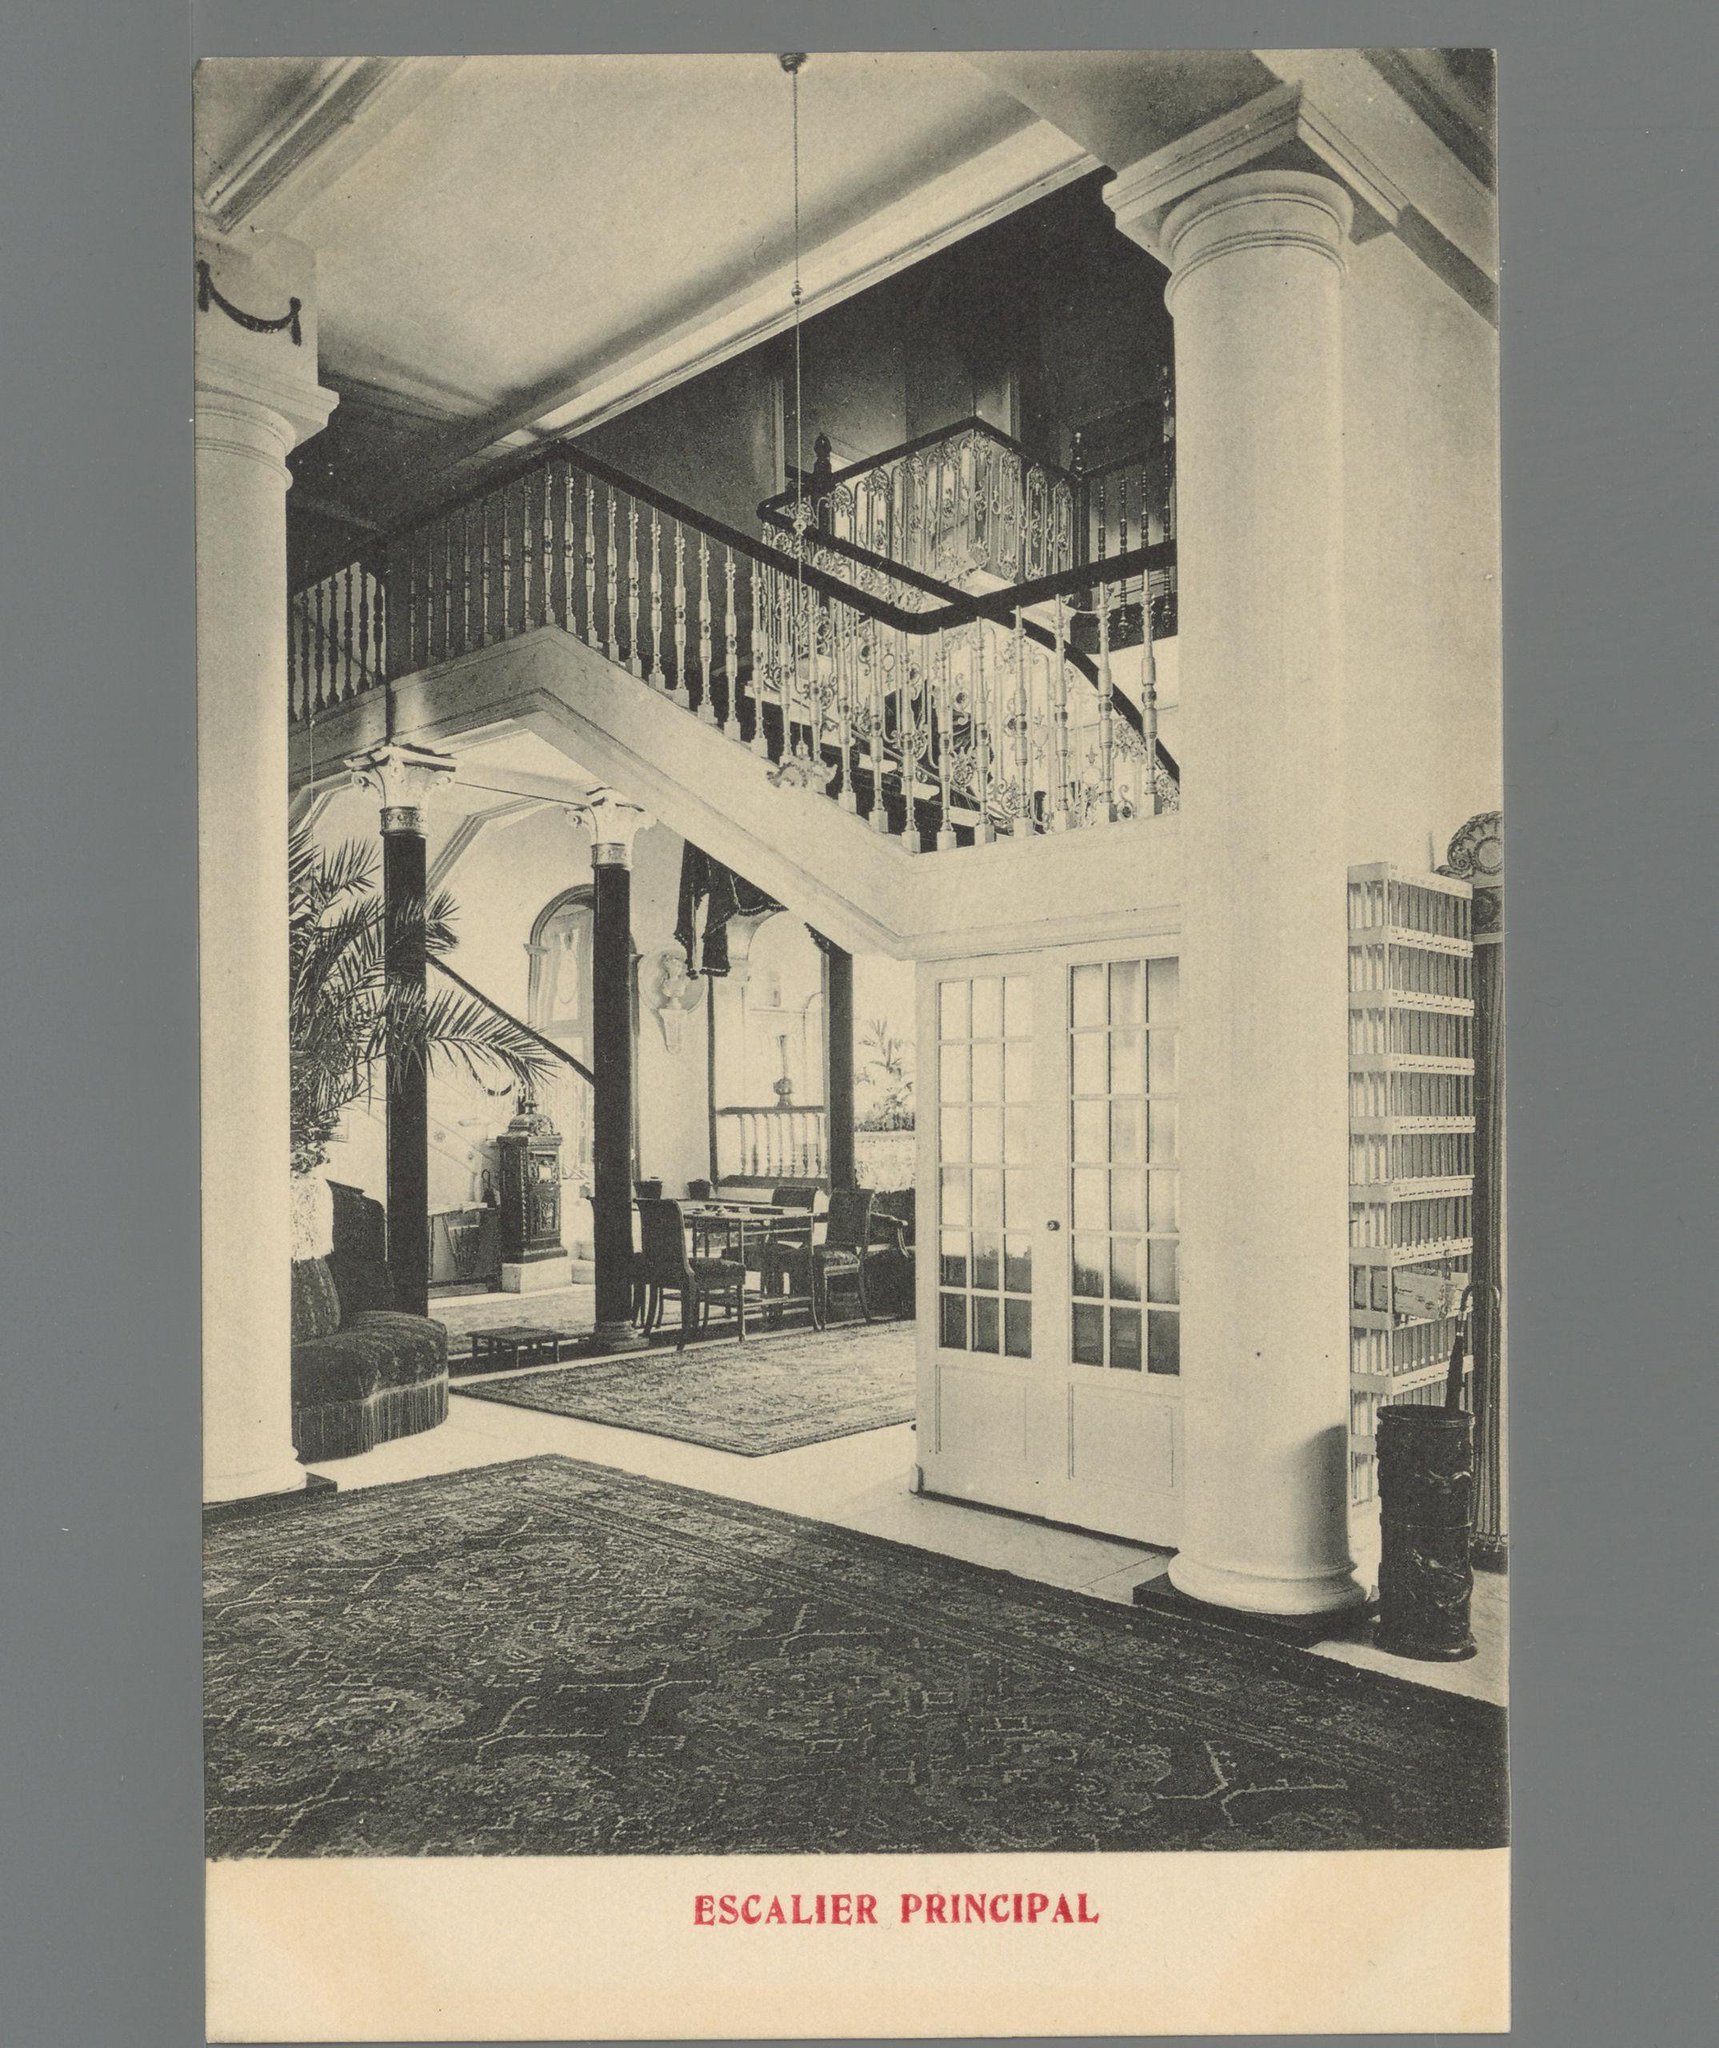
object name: photomechanical print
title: Hôtel du Littoral. Ostende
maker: Anonymous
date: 1906-1914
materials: cardboard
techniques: photograph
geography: oostende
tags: staircase, interior ~ representation of a building, hotel, hostelry, inn